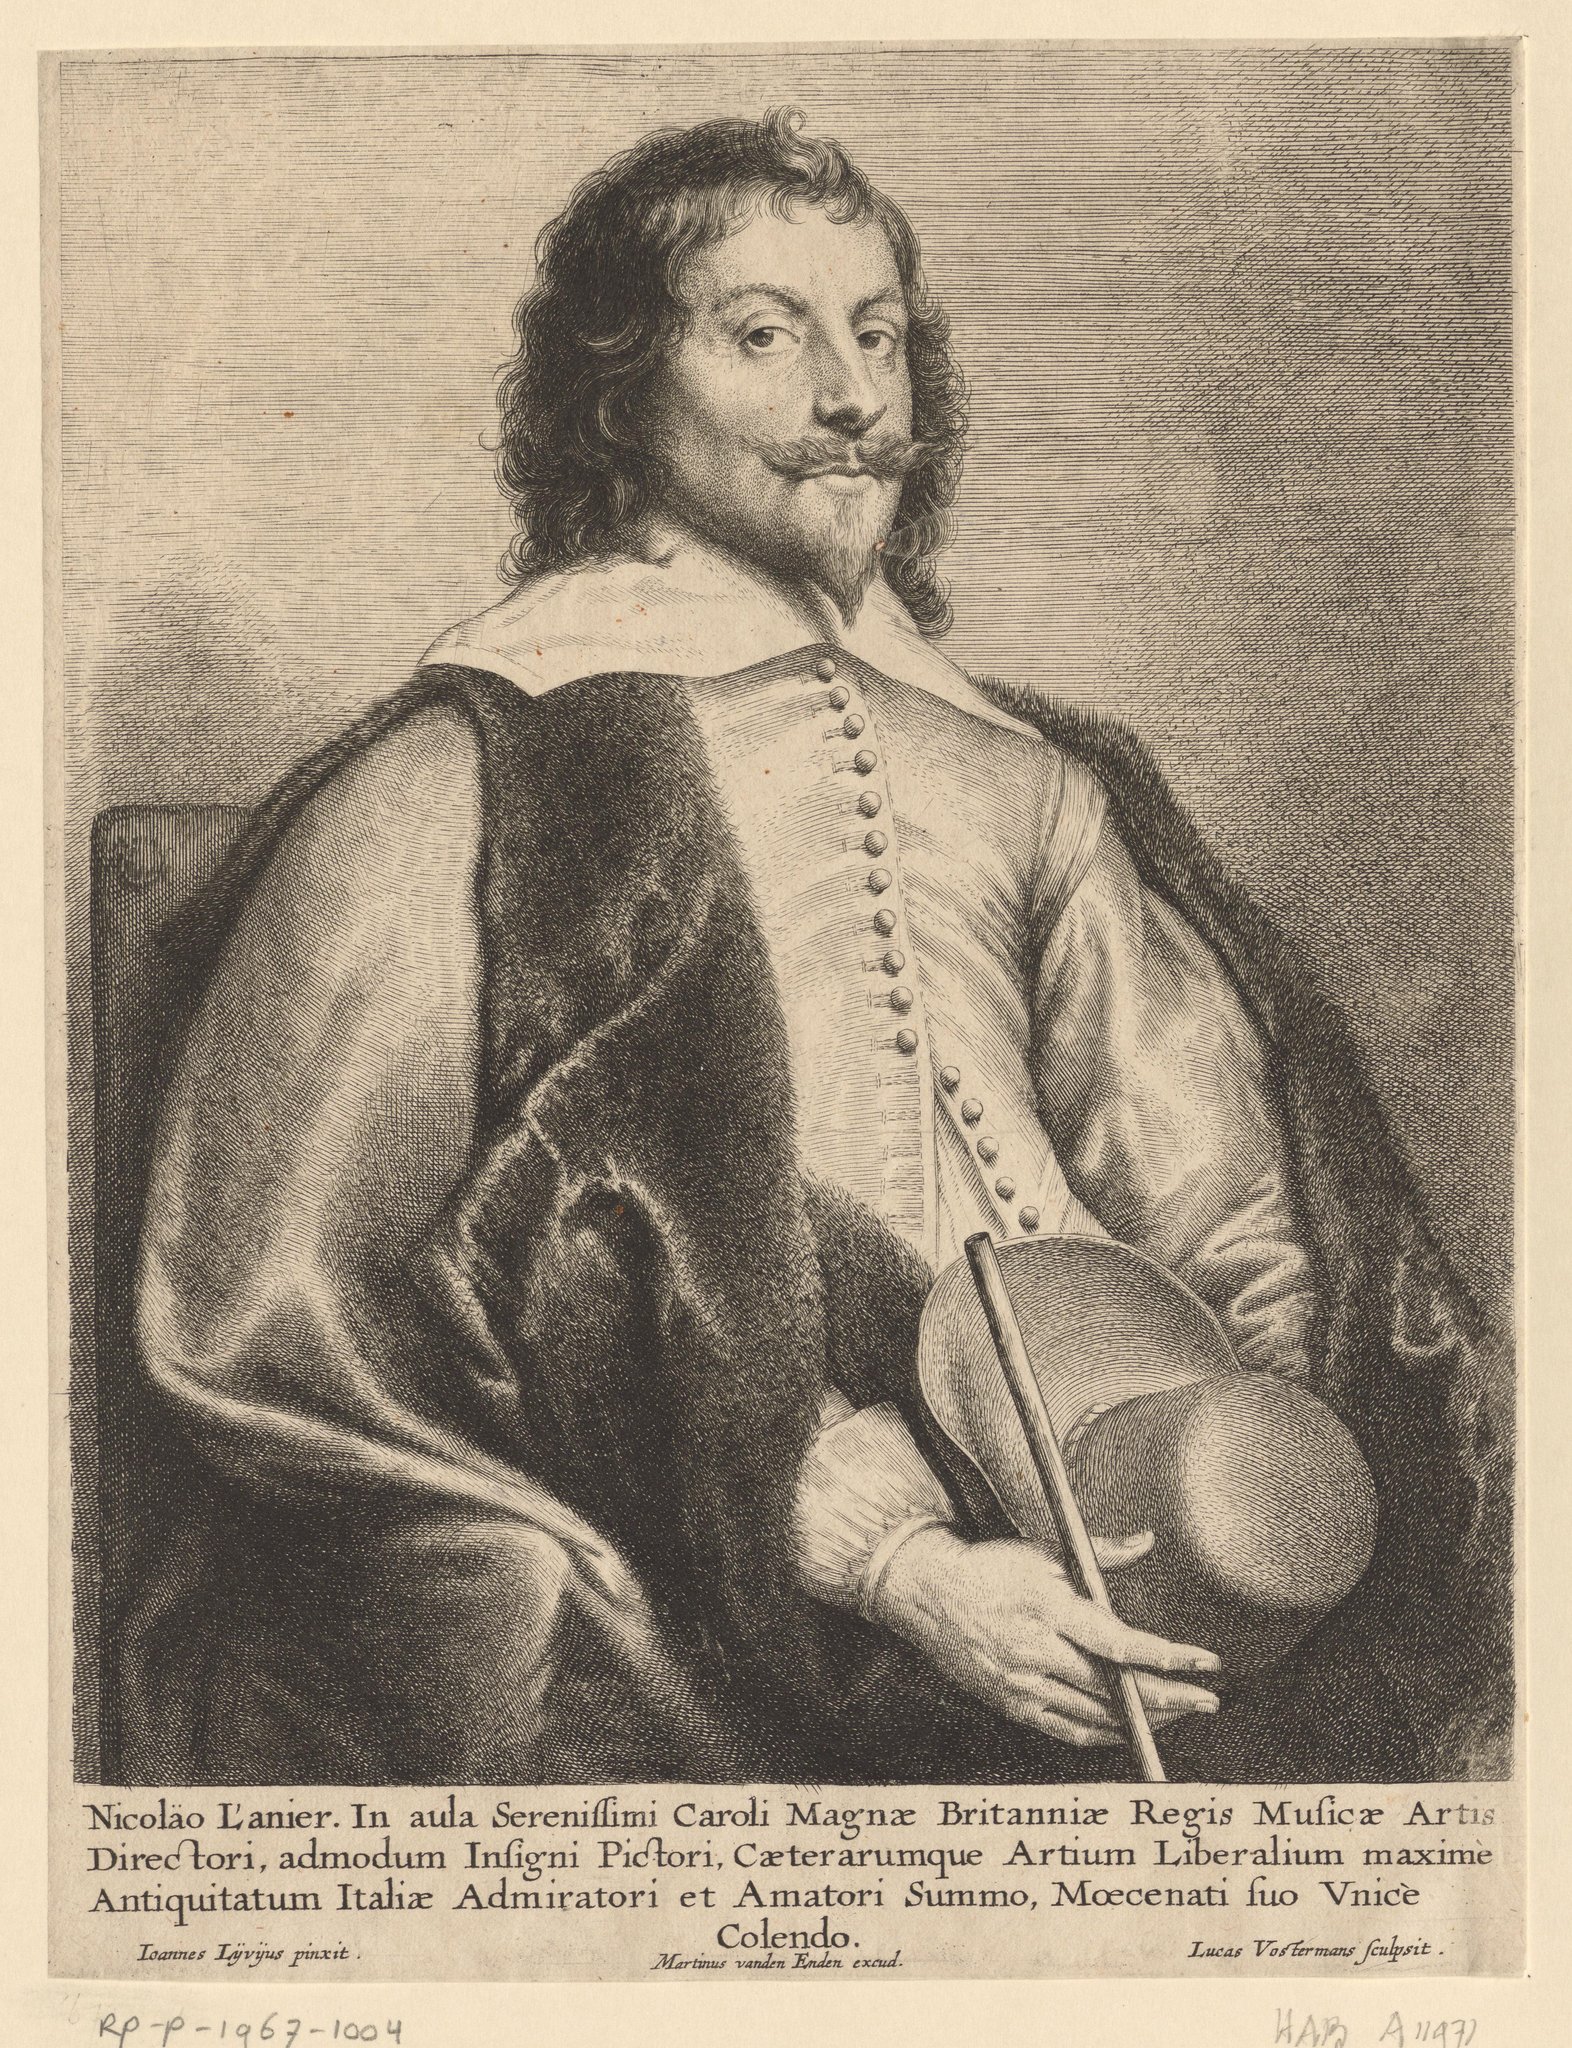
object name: print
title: Portret van Nicholas Lanier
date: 1630-1674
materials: paper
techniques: engraving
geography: antwerp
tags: london, painter, historical persons, portrait of composer, head-gear: hat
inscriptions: collector's mark: Lugt 2228